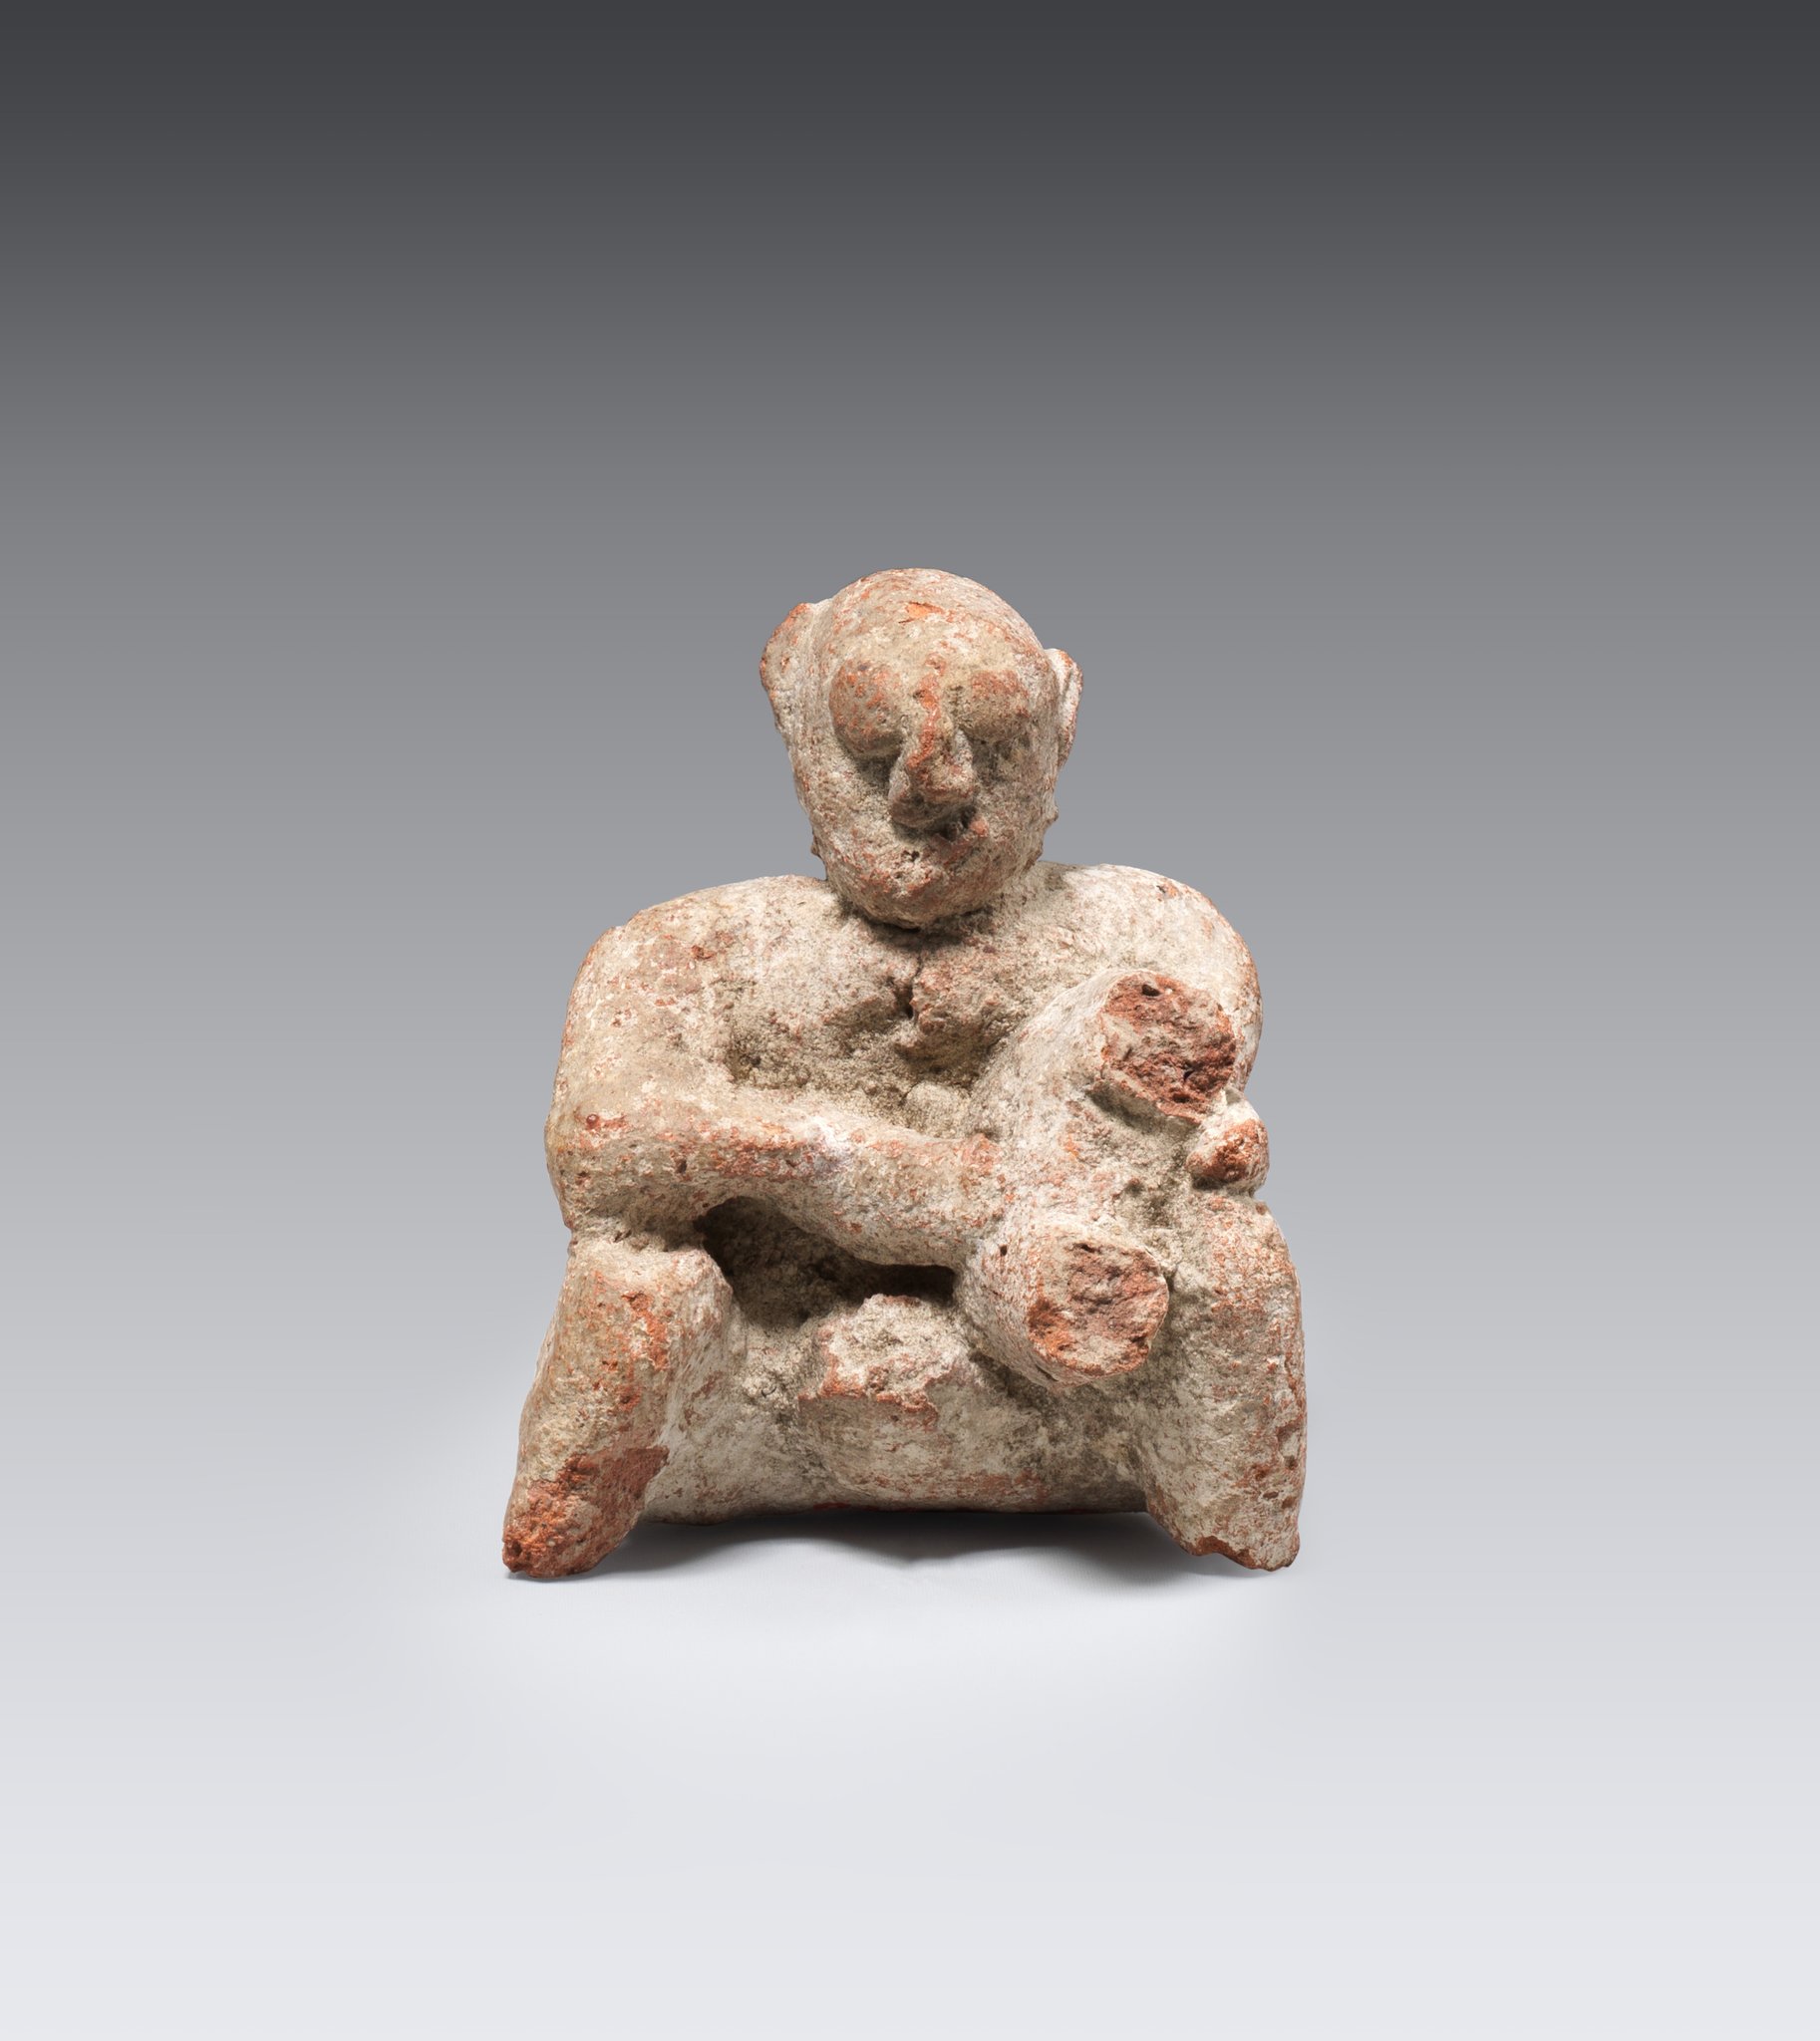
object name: figurine, man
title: Figure of a seated man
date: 306-30 BCE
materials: paint, pottery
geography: egypt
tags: men